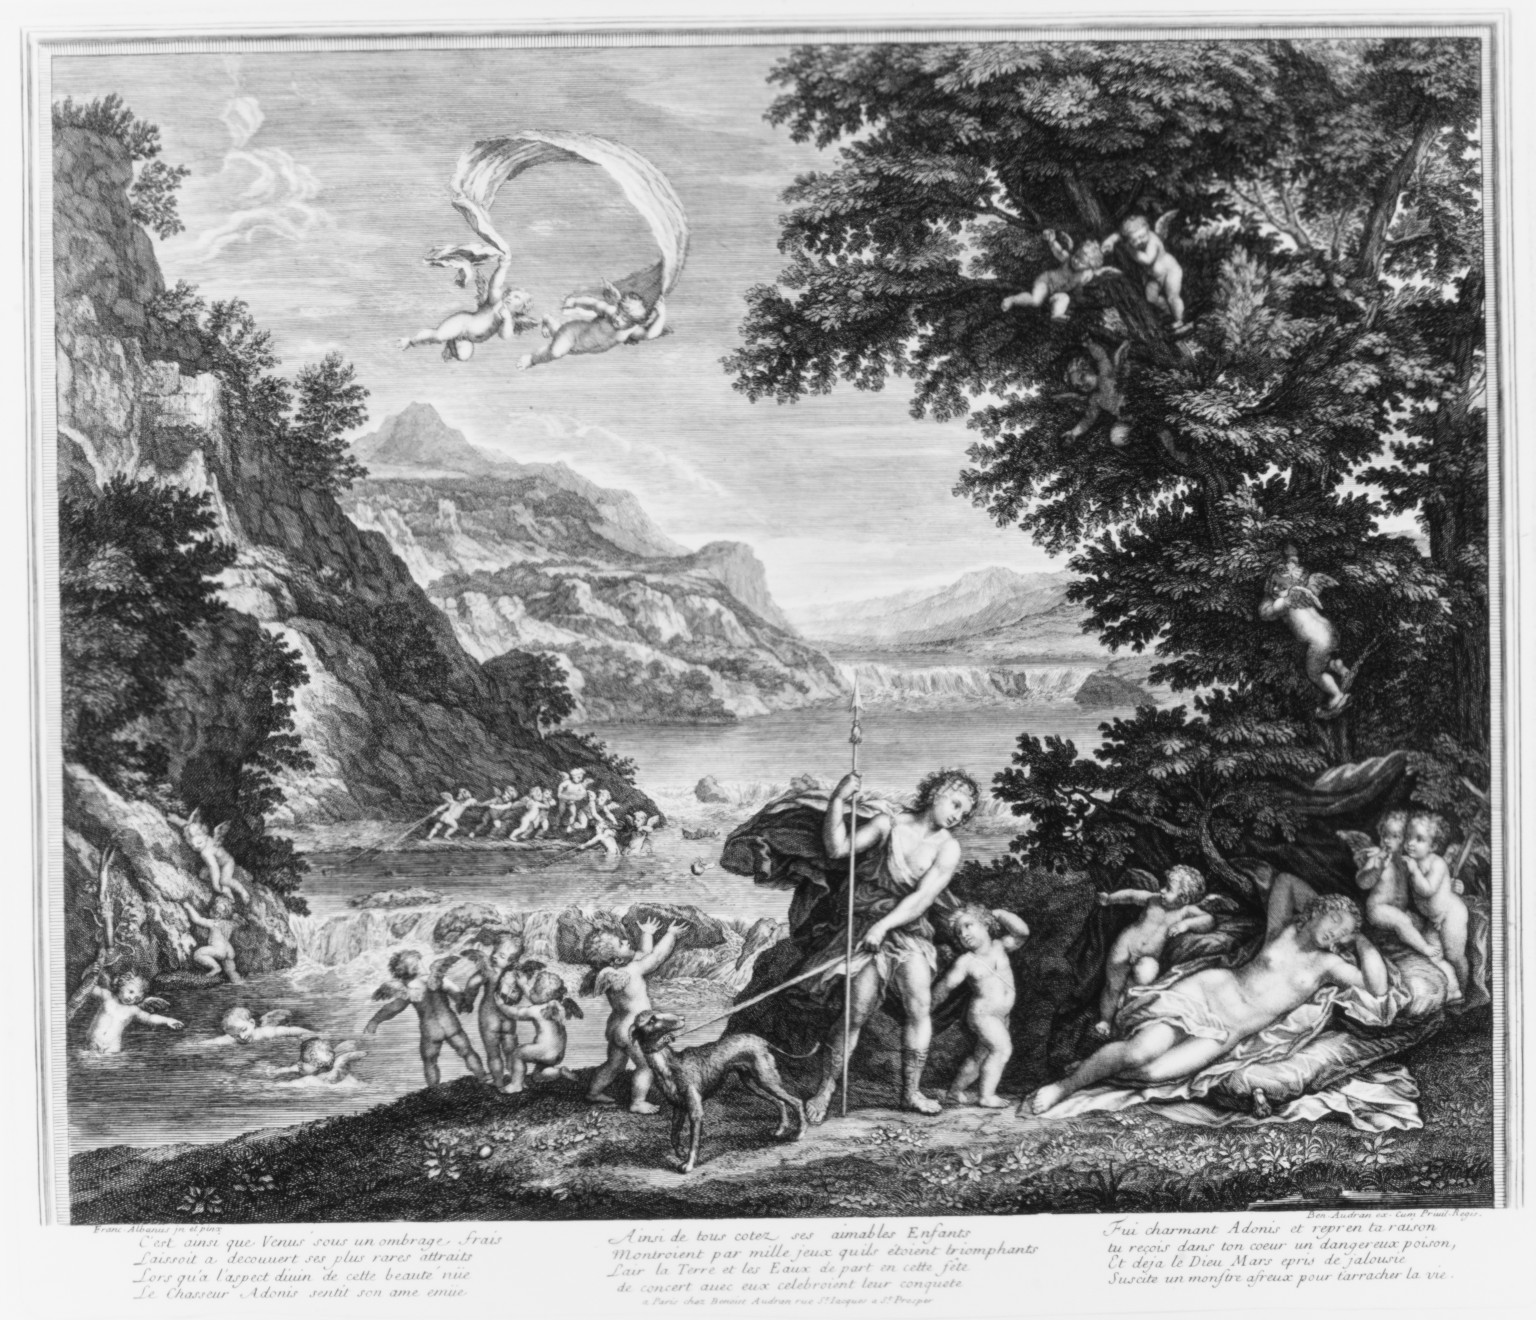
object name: print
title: The Loves of Venus and Adonis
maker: francesco albani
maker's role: artist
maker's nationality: italian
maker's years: 1578-1660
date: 1741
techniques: engraving, etching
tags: swimming,cupid,adonis,venus,dogs,rivers,hills,trees